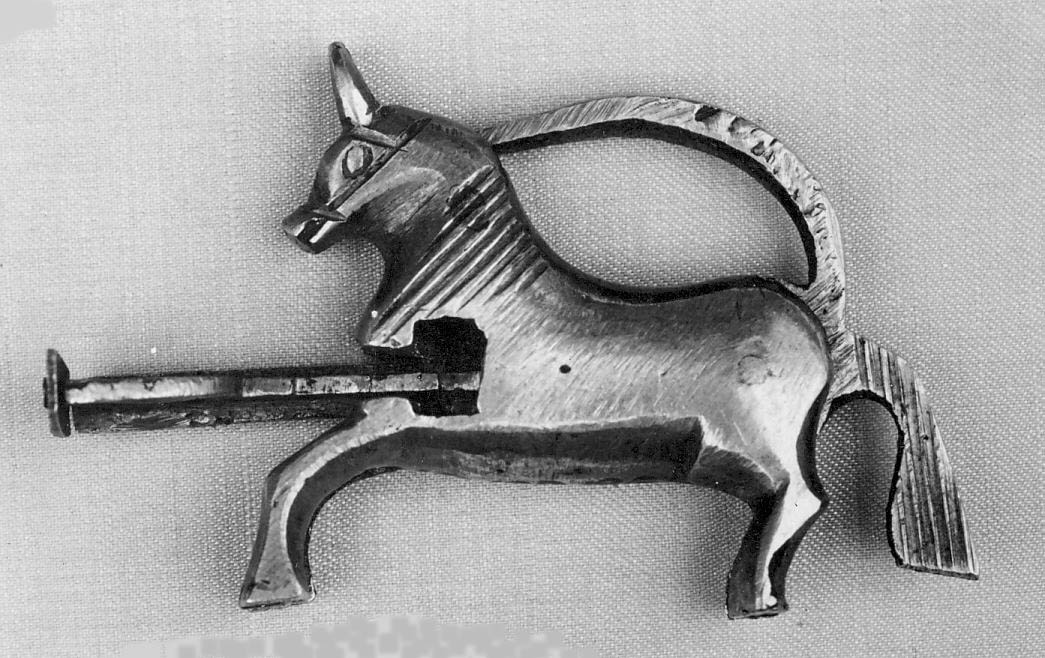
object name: padlock with key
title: Padlock in the Shape of a Galloping Horse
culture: indian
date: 1701-1800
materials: bronze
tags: horses